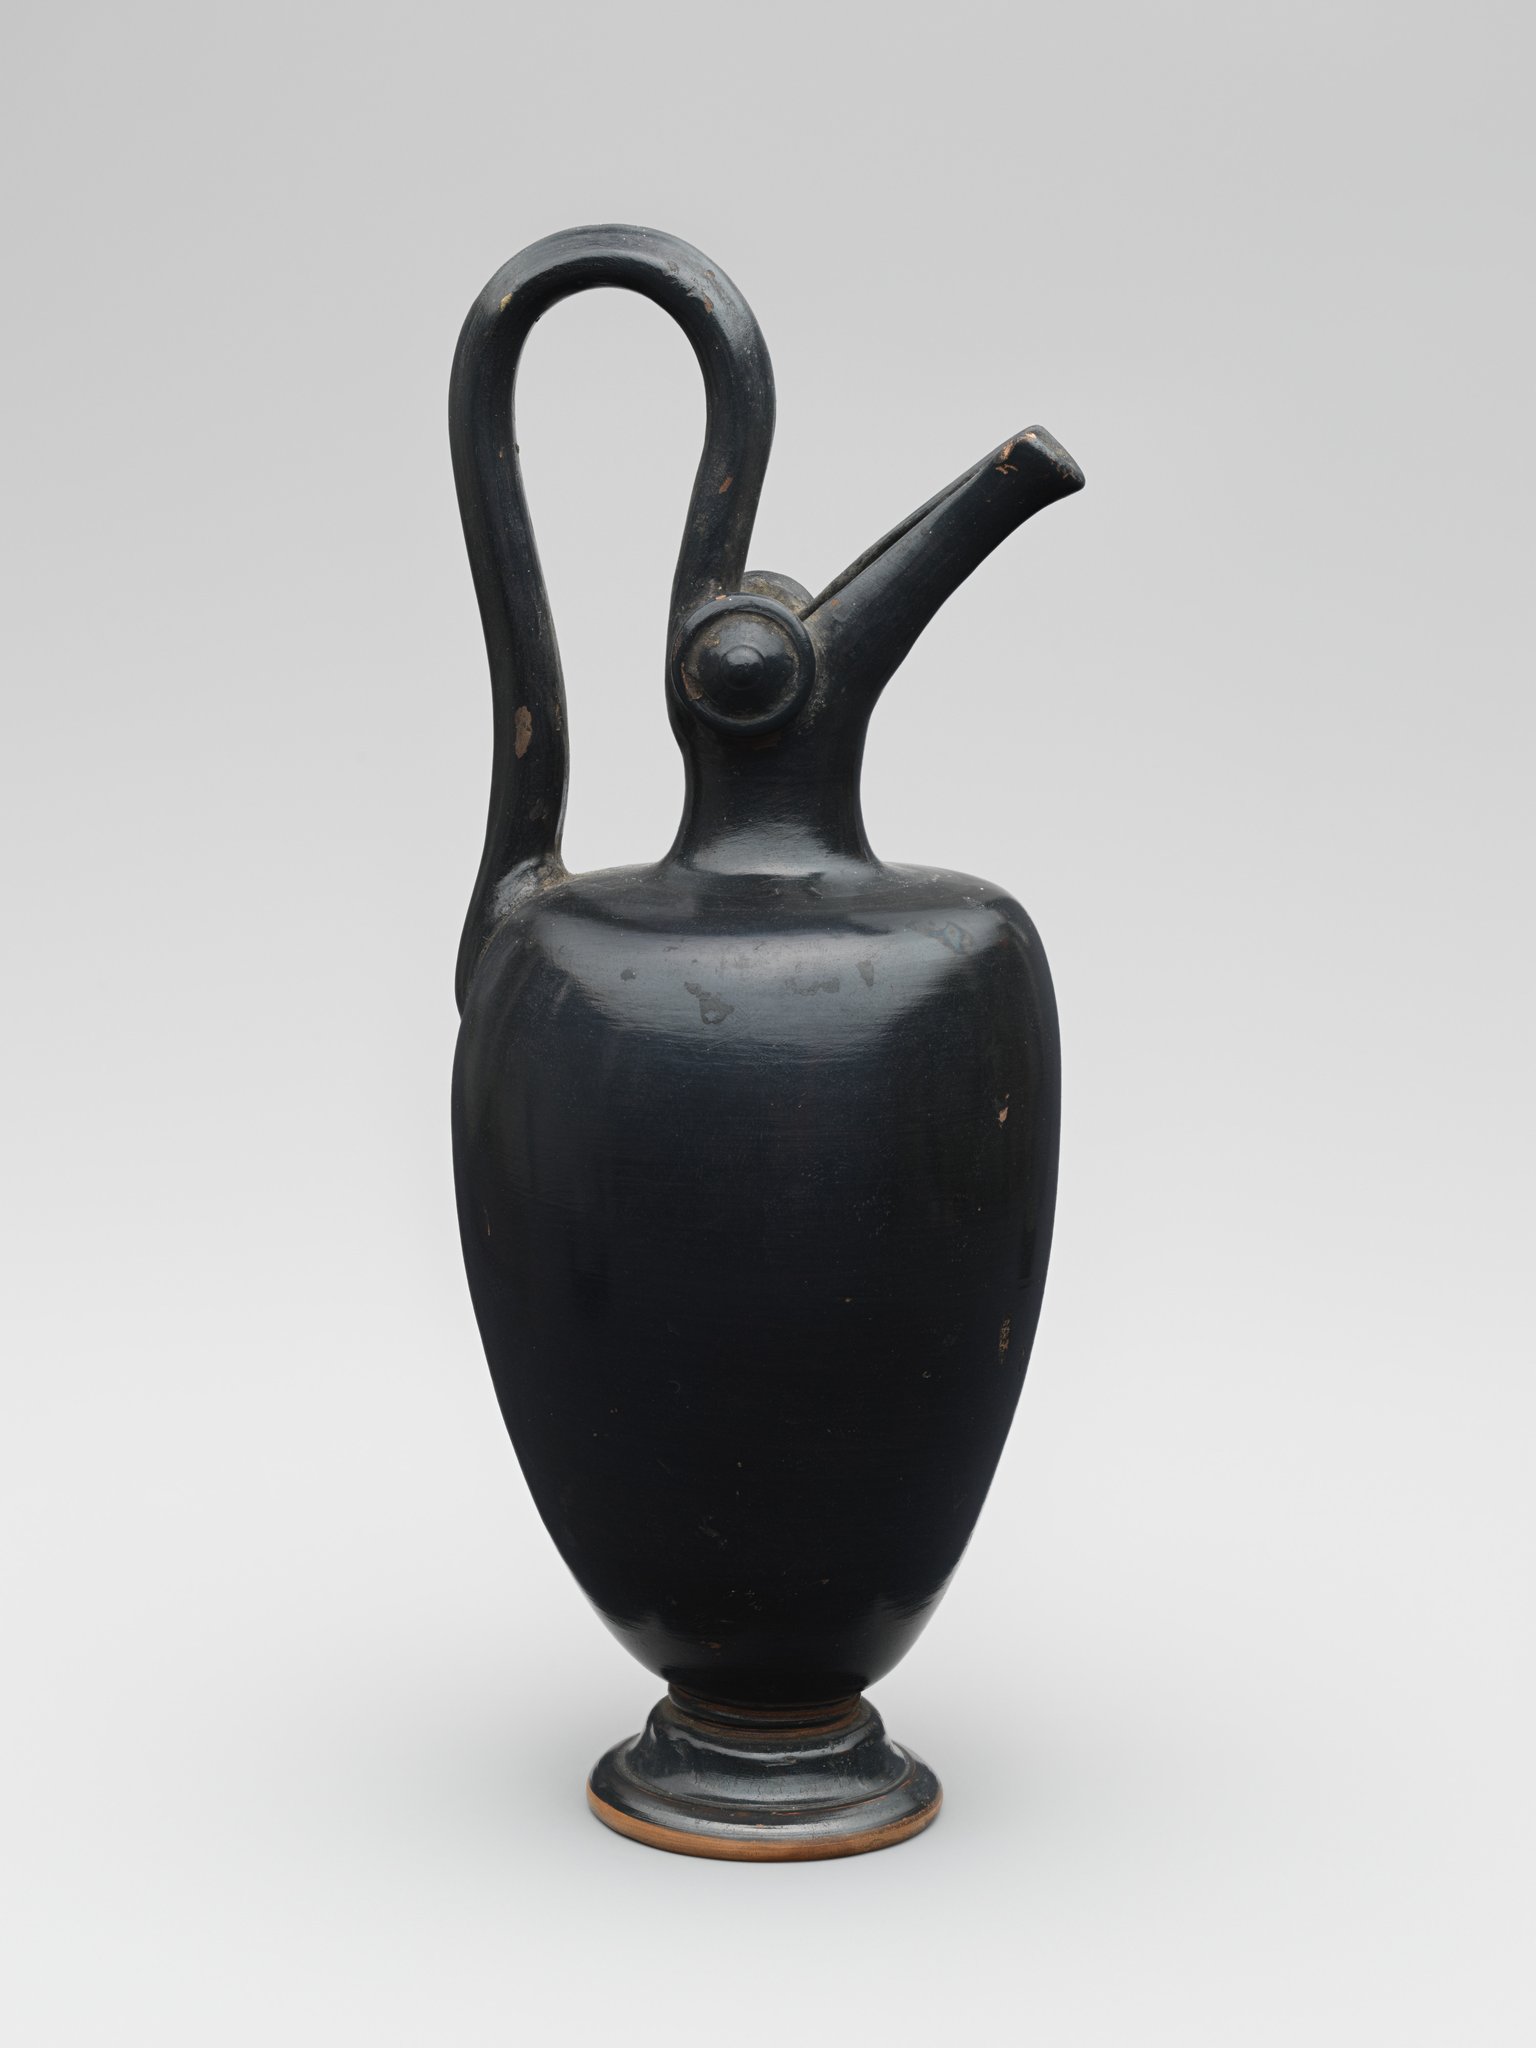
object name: oinochoe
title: Terracotta oinochoe (jug)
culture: greek, attic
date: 434-401 BCE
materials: terracotta